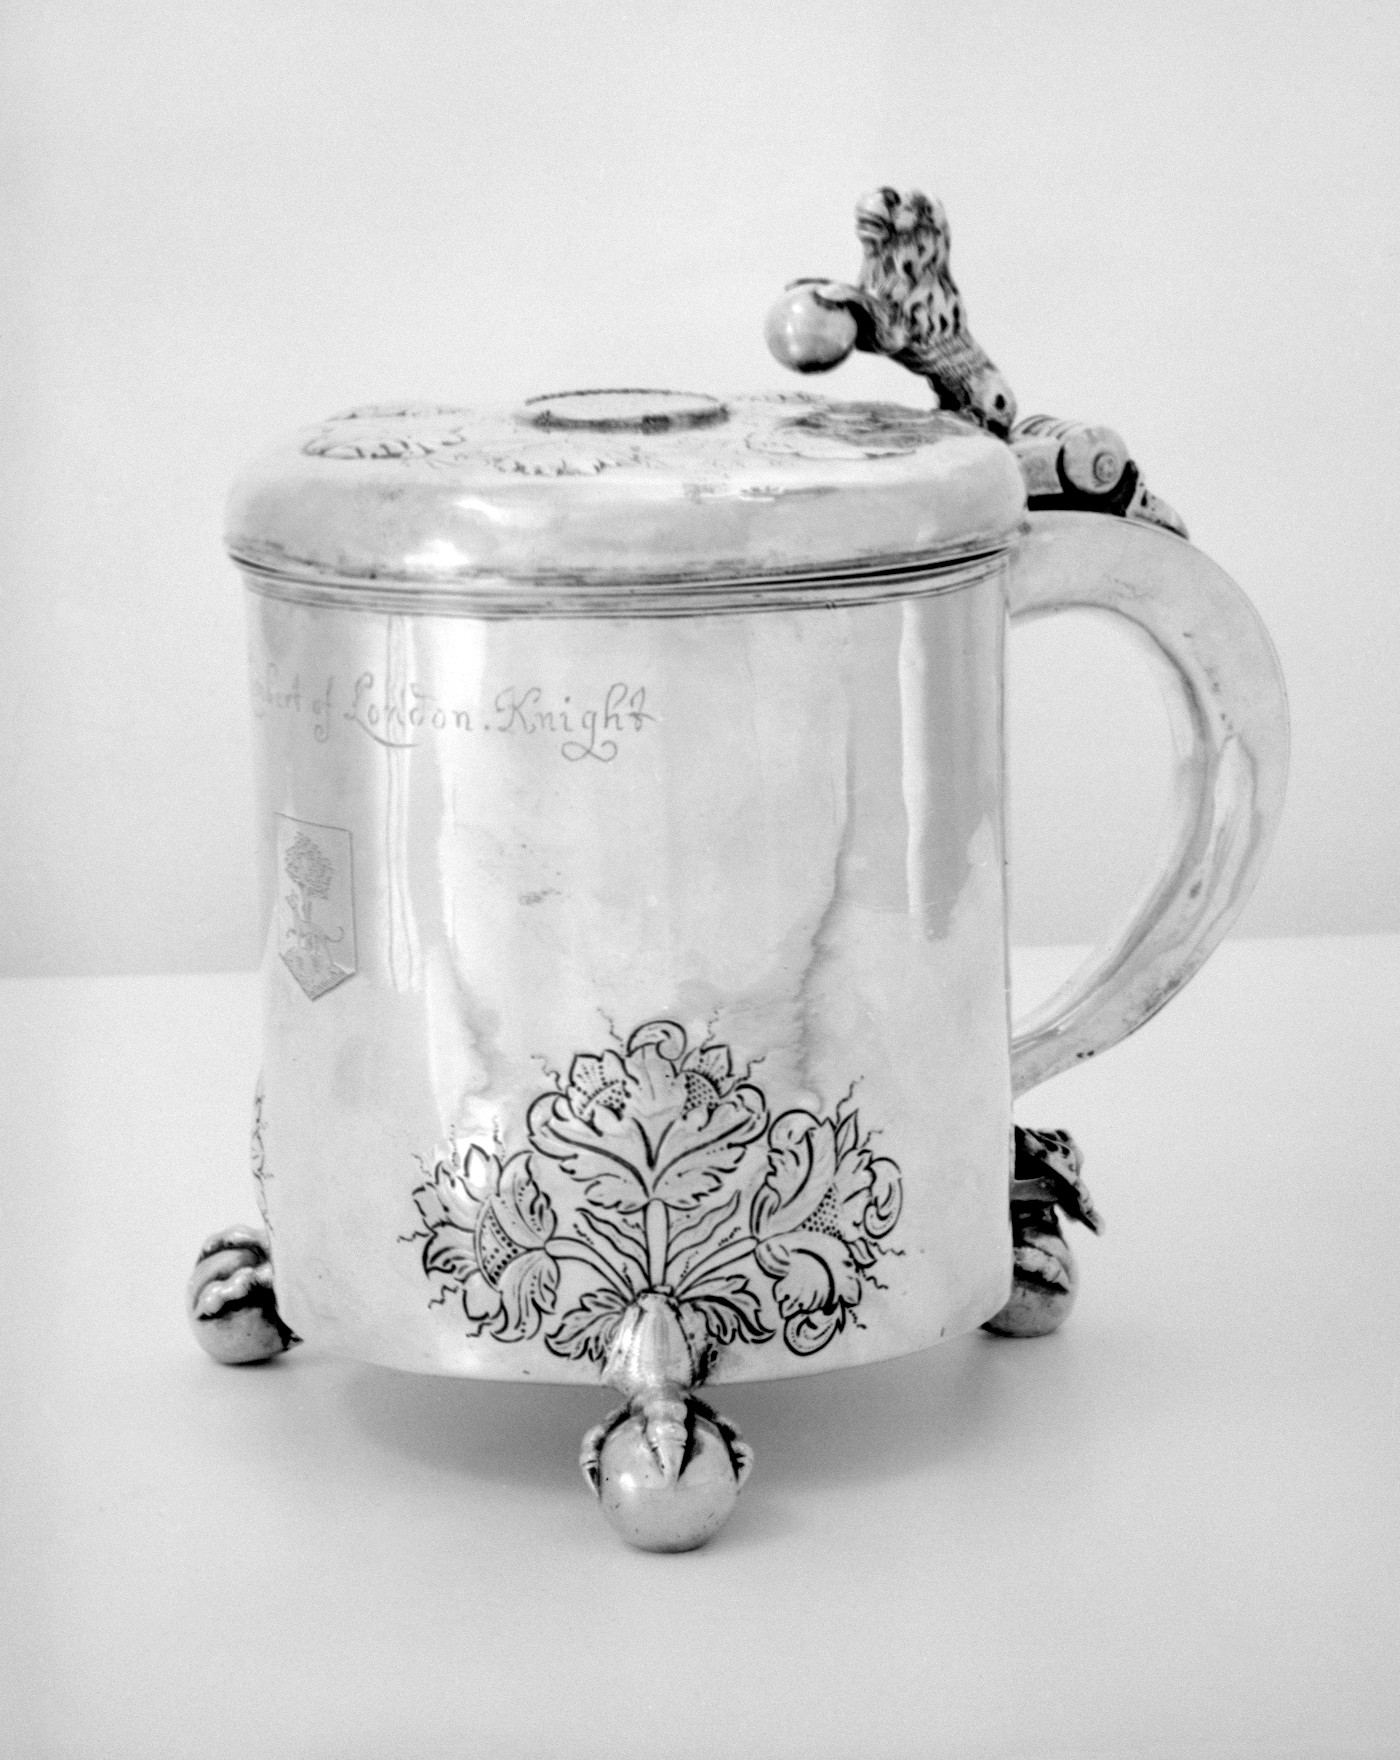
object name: peg tankard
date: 1676-1700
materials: silver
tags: flowers